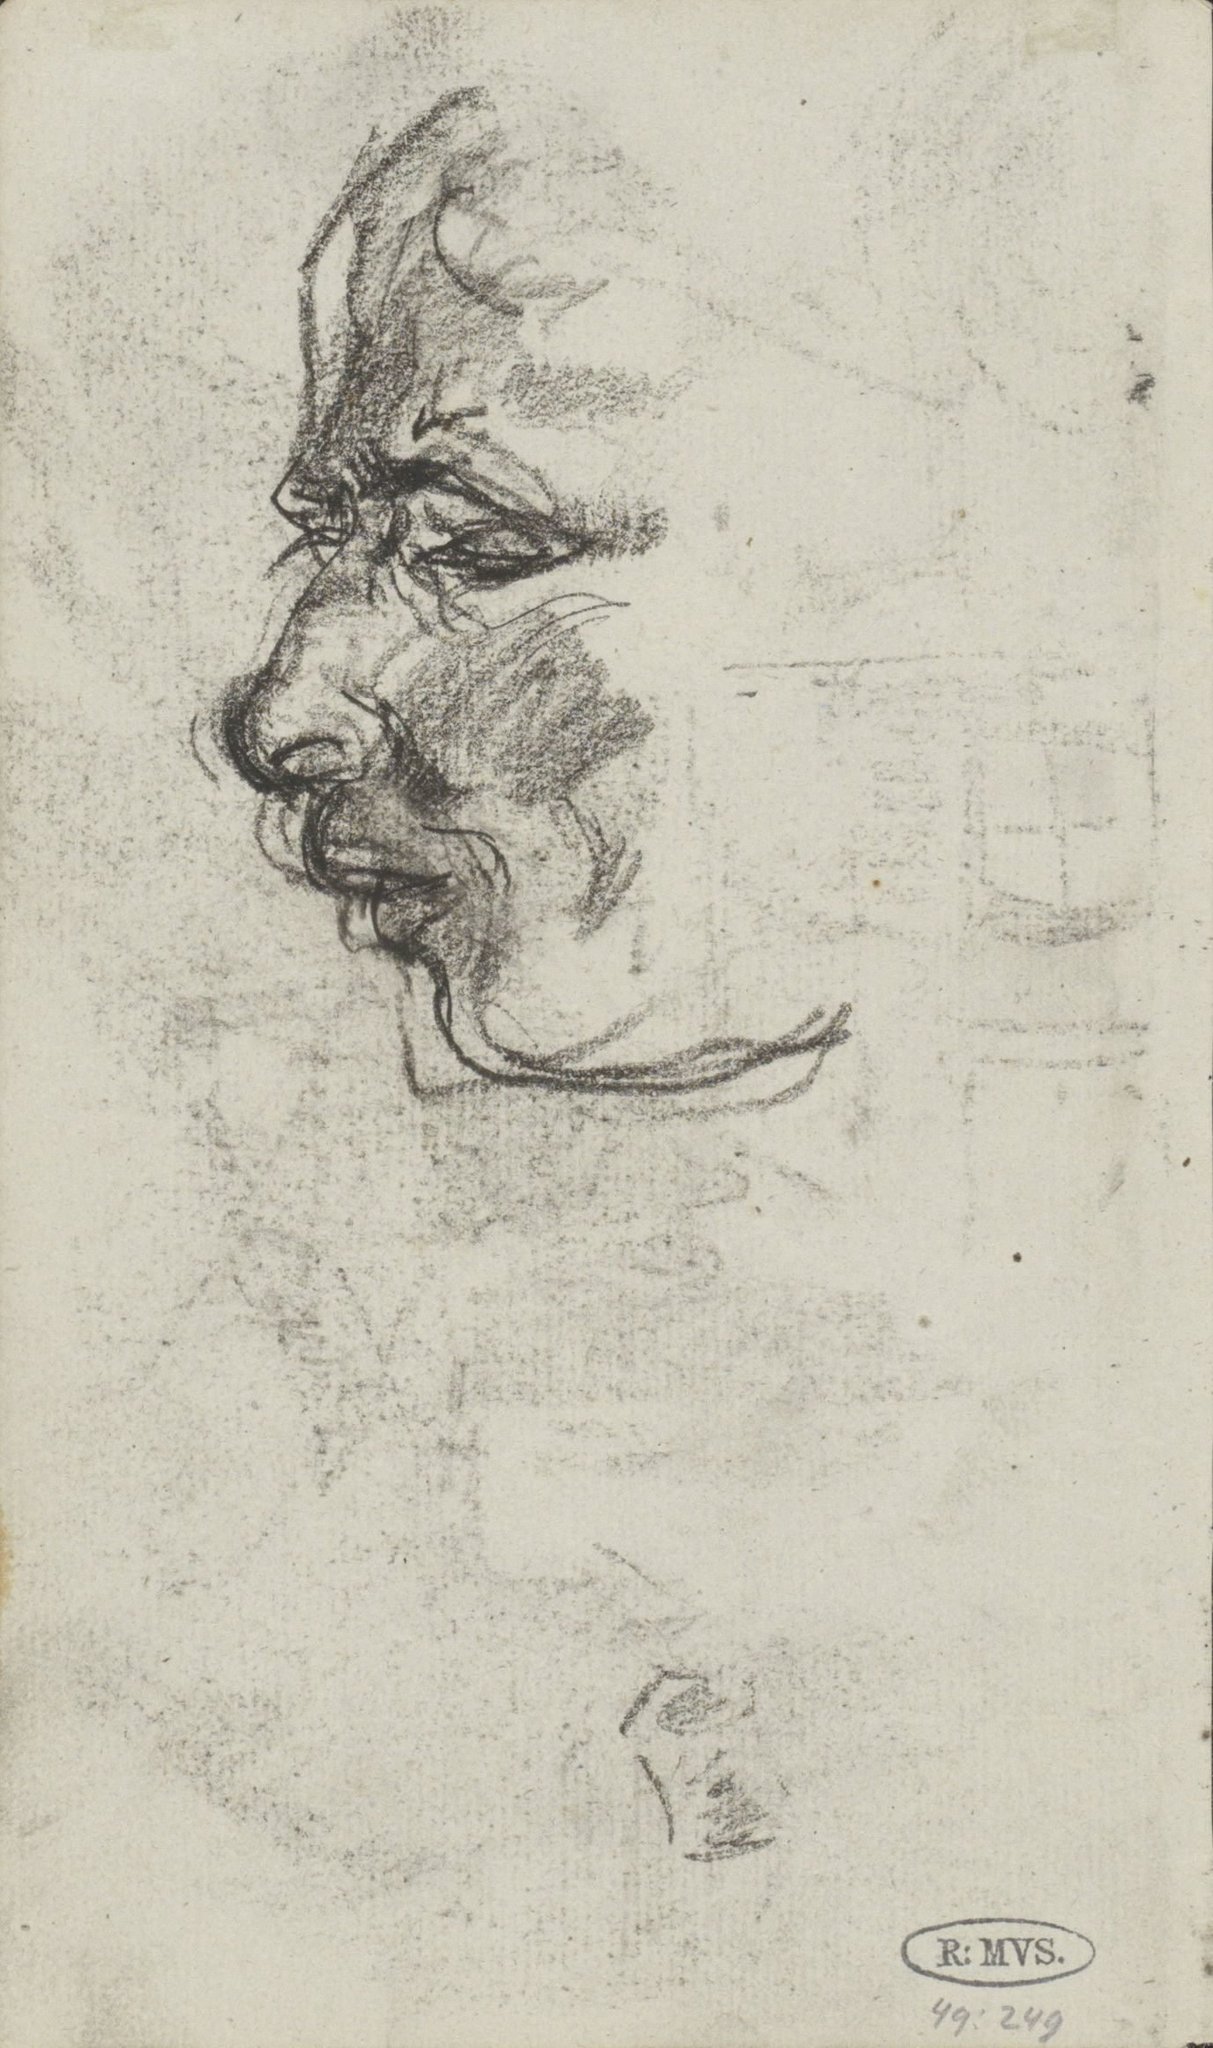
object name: drawing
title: Gezicht, naar links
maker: george hendrik breitner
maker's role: draughtsman, painter, print maker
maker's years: 1857-1923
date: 1882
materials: chalk, paper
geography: rotterdam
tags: face (+ sideview, profile)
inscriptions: collector's mark: Lugt 2228